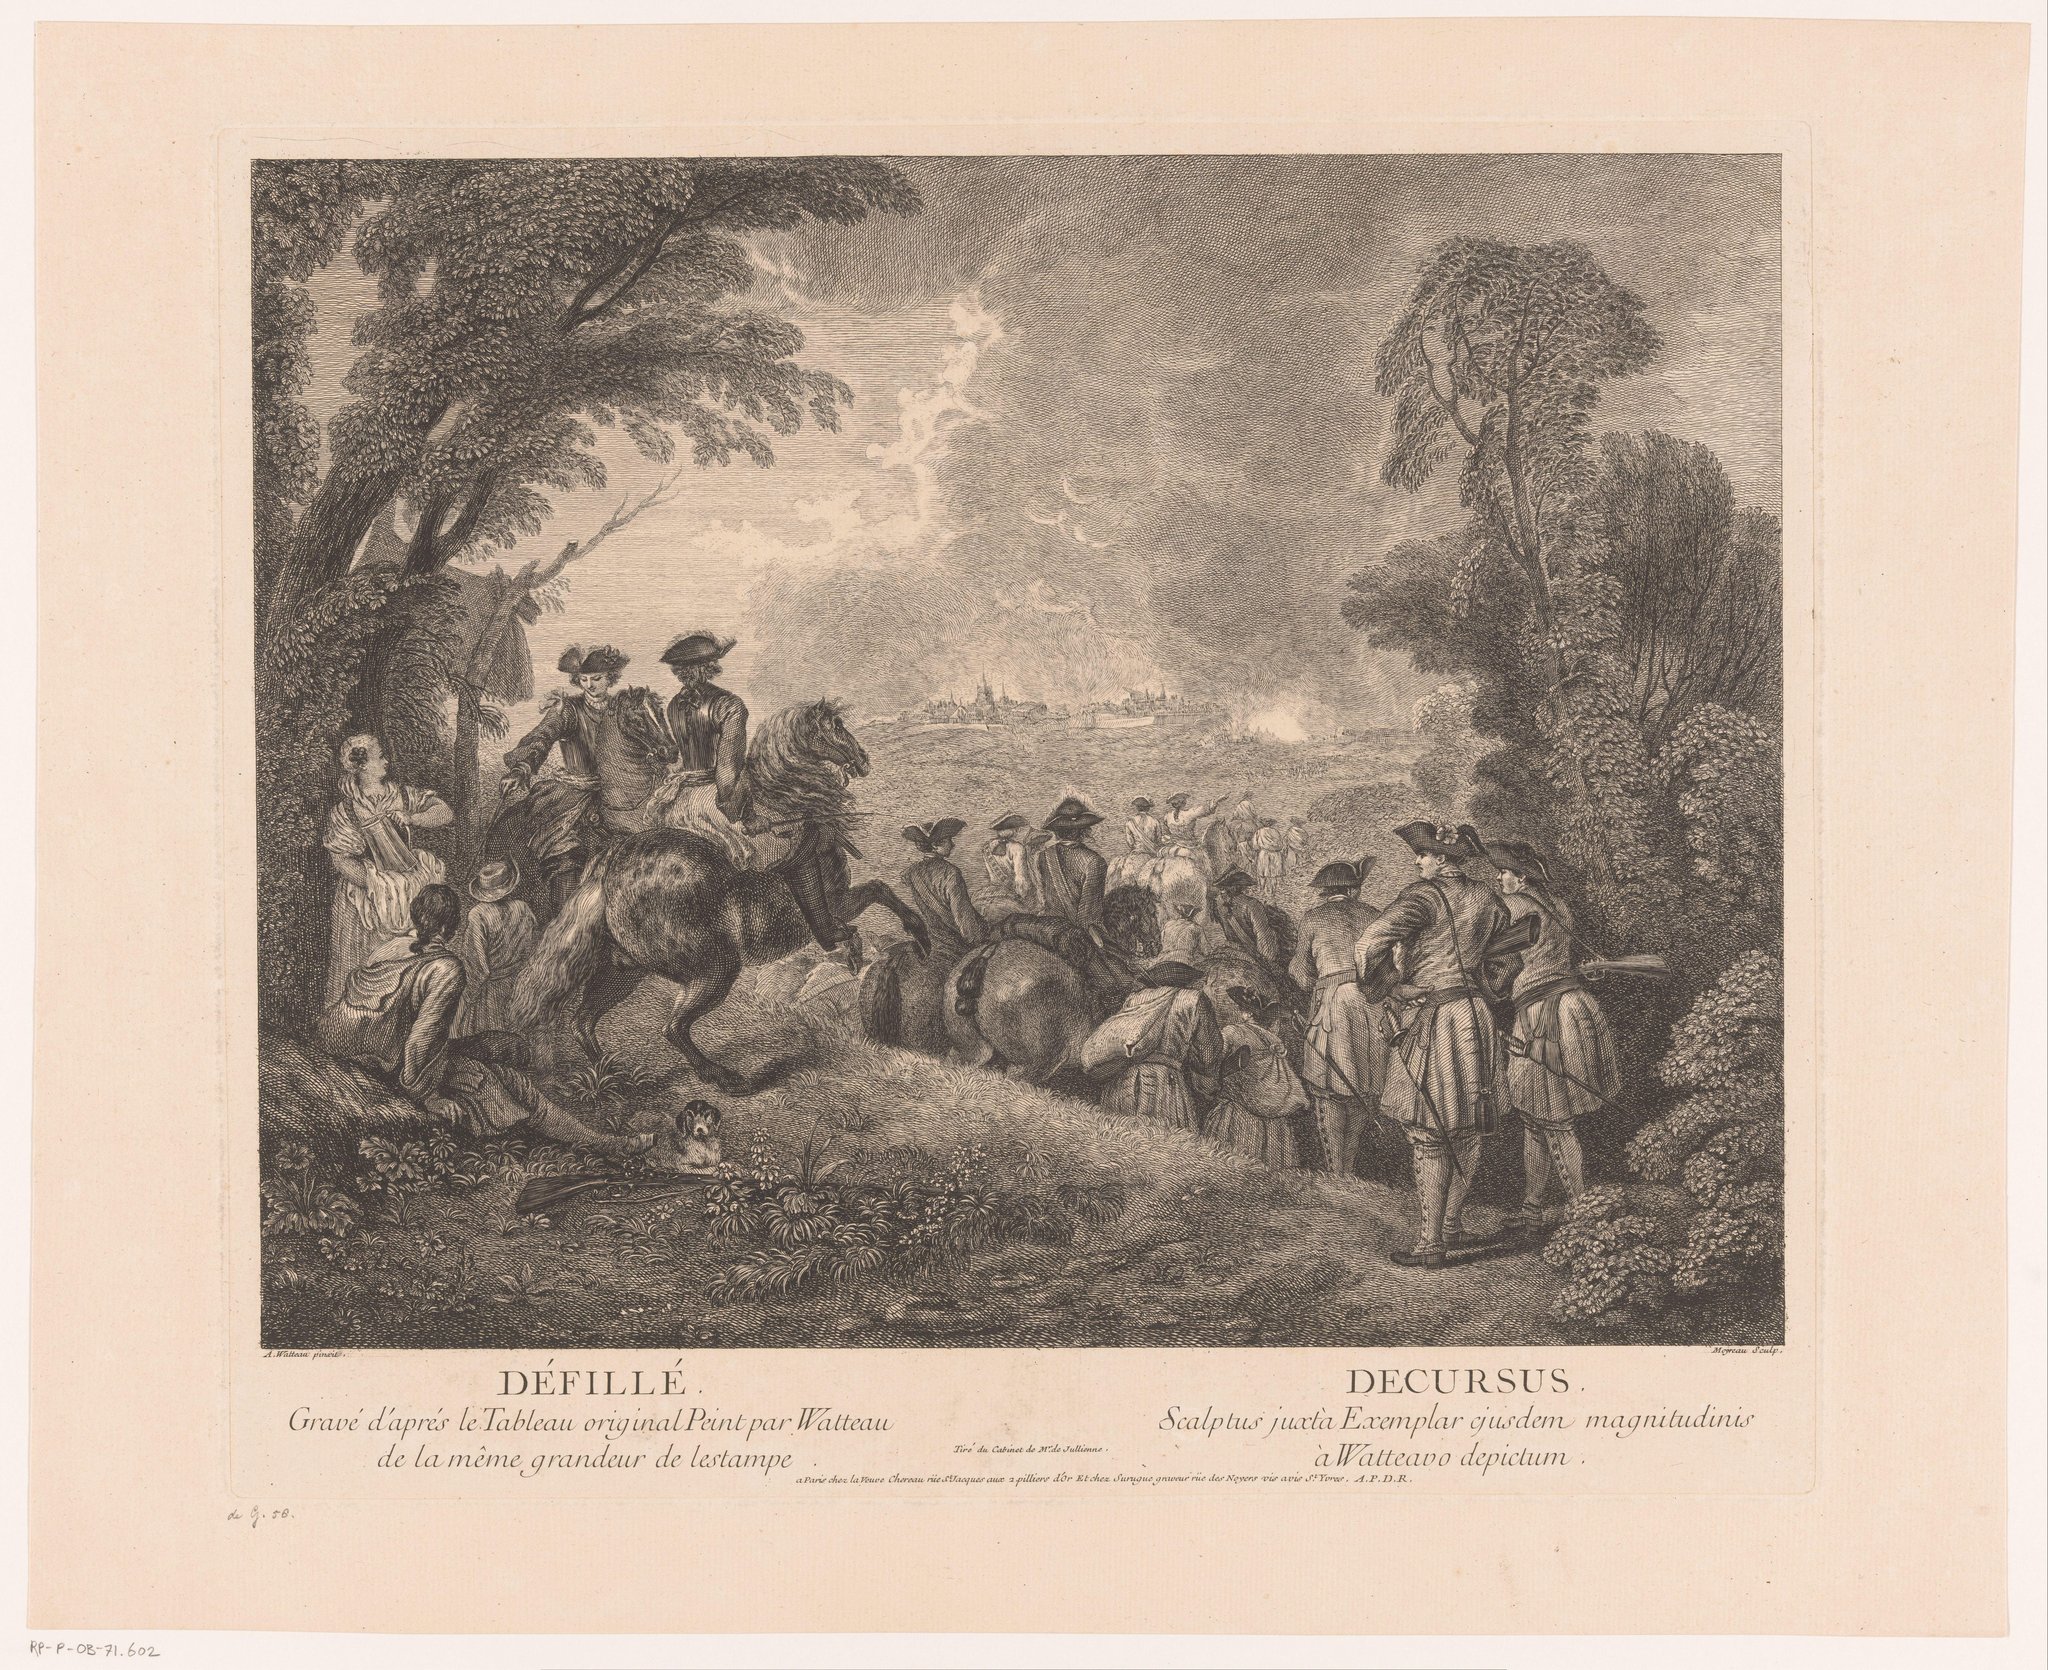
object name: print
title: Optocht met soldaten onderweg naar een belegerde stad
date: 1726-1735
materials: paper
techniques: engraving, etching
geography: paris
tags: liberation of besieged city, military parade, pageant, outskirts of village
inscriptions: collector's mark: Lugt 2228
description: Maakt deel uit van een serie van 271 platen naar schilderijen door Watteau, verdeeld over drie delen, gecoördineerd door Jean de Jullienne en uitgegeven in Parijs tussen 1726 en 1735. Sommige platen werden reeds tijdens Watteau's leven gemaakt. Dit betreft plaat 225.